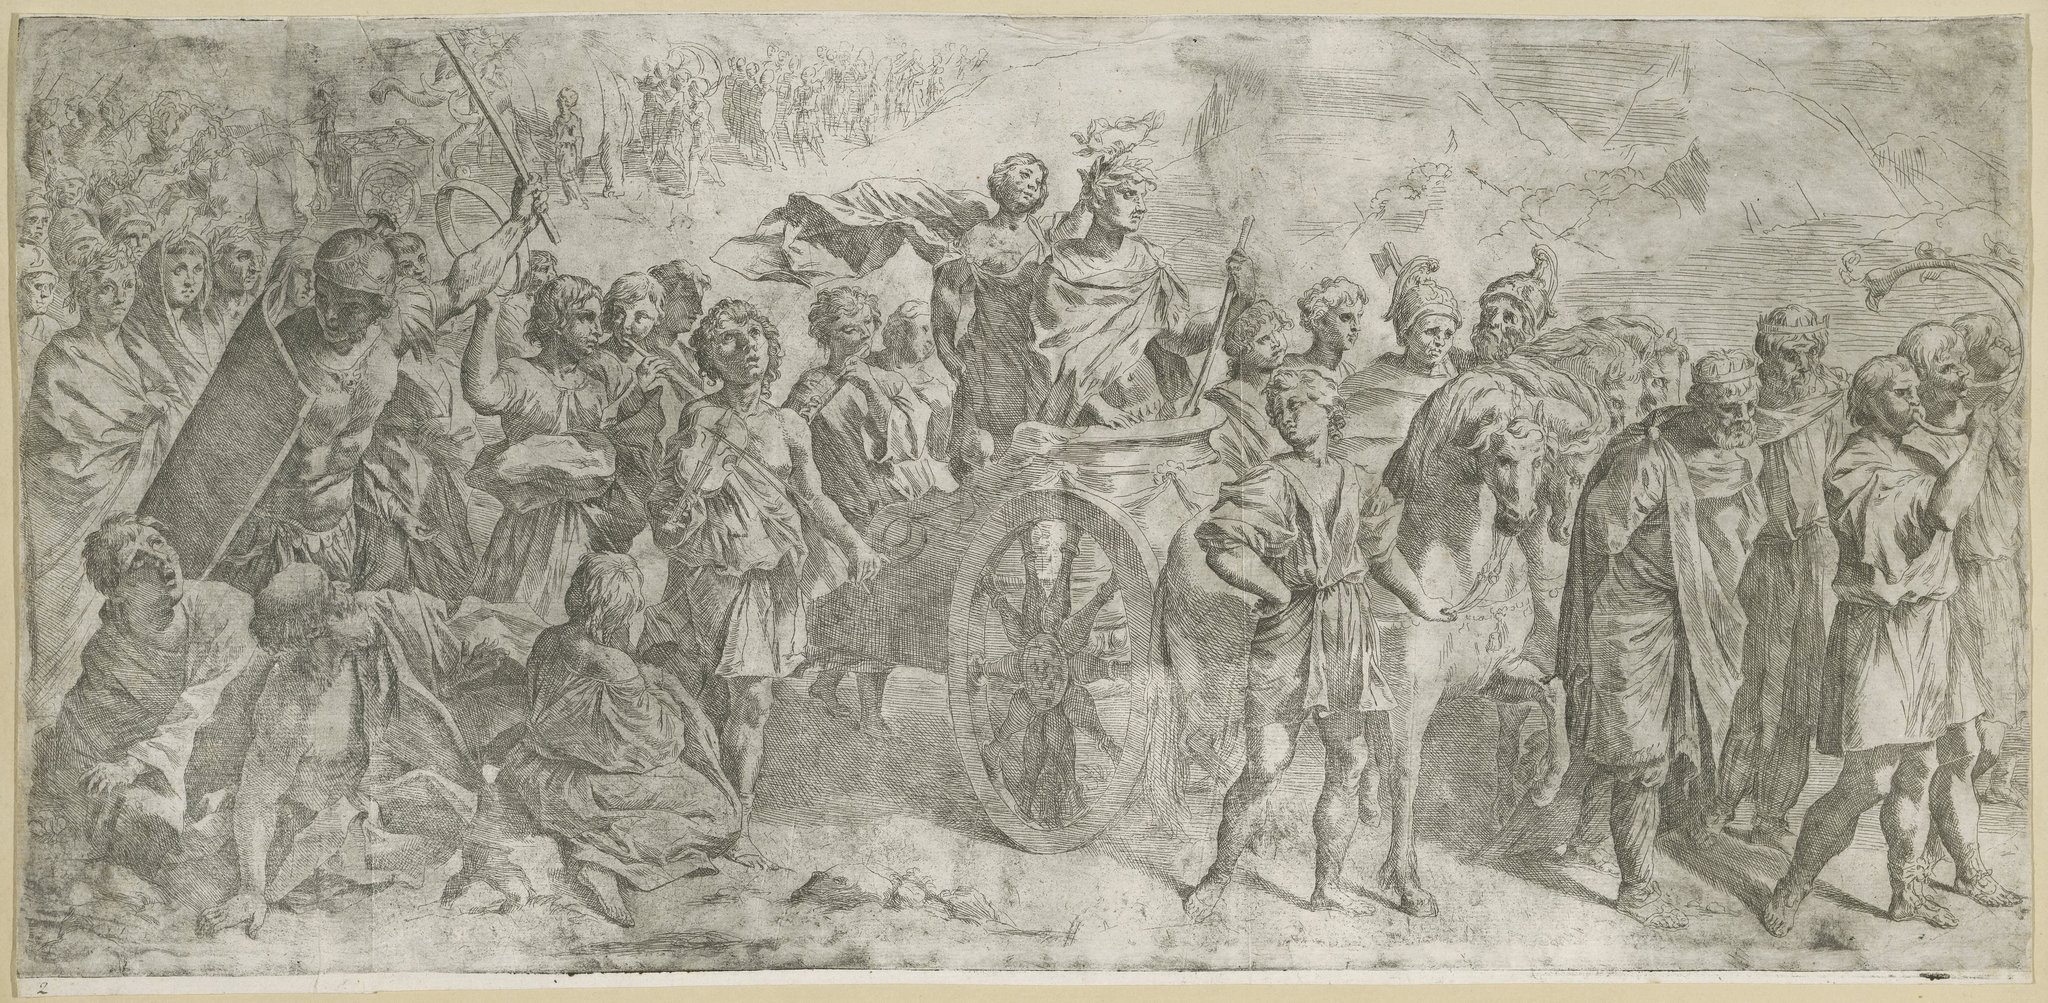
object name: print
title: Triomf van een Romeins keizer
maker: giovanni lanfranco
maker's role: draughtsman, painter, print maker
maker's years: 1582-1647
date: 1592-1647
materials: paper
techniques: etching, intaglio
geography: italy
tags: triumphal entry and public reception, pageant, 'entrée solennelle', 'joyeuse entrée', chariot, triumphal car, emperor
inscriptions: collector's mark: Lugt 11, number: ‘2’, collector's mark: Lugt 10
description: Een Romeinse keizer op een triomfwagen in een stoet van soldaten en muzikanten.